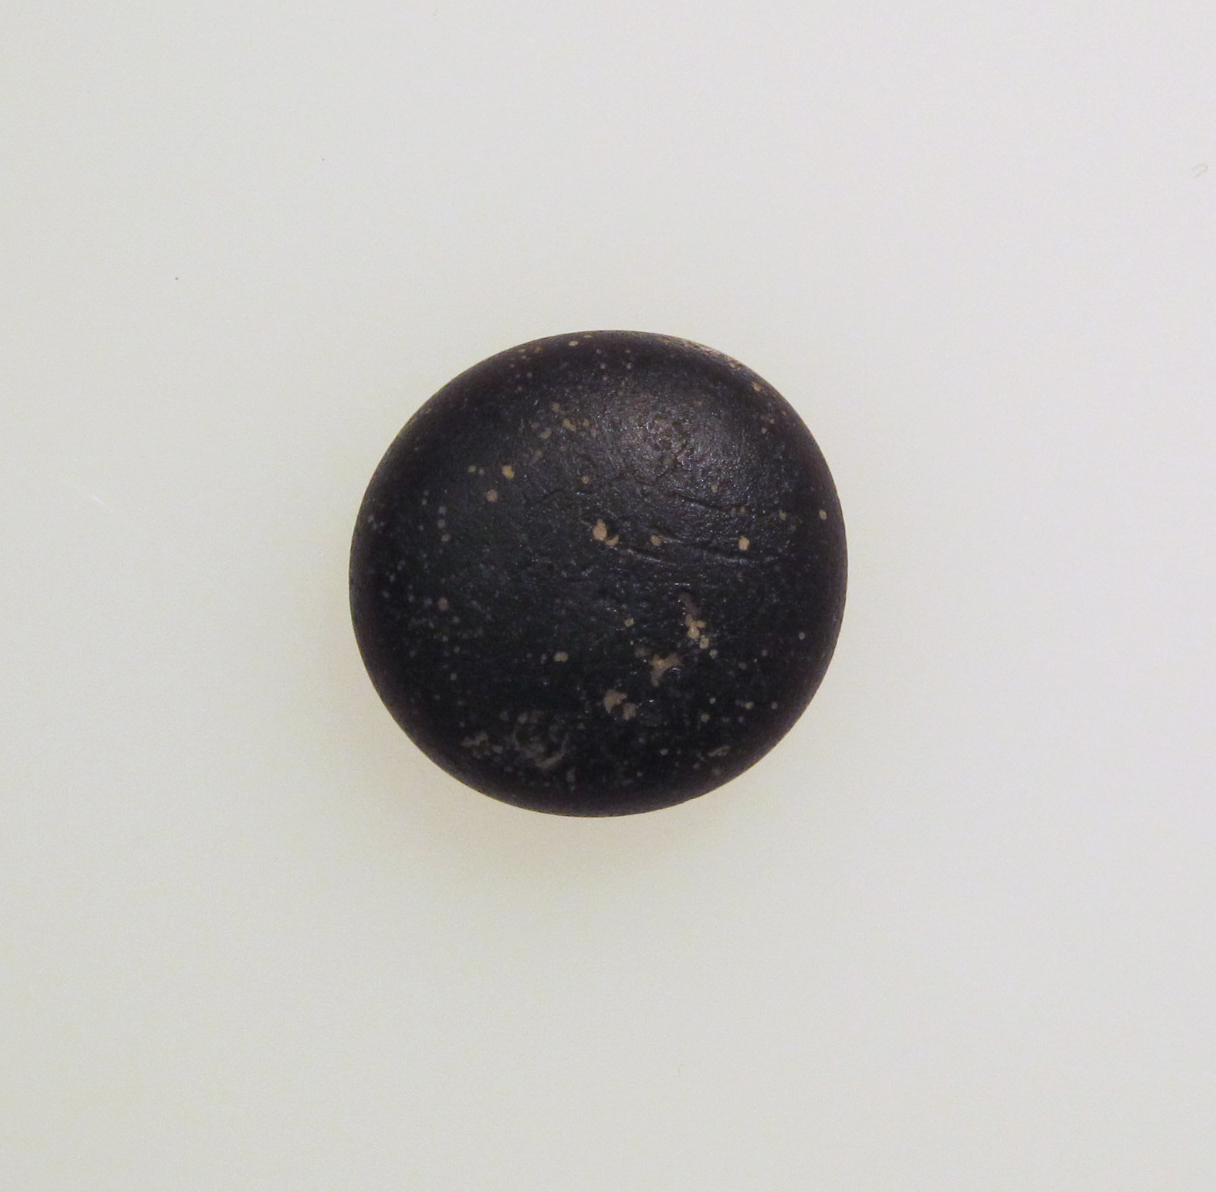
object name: pinhead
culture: roman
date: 100 BCE-500 CE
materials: glass